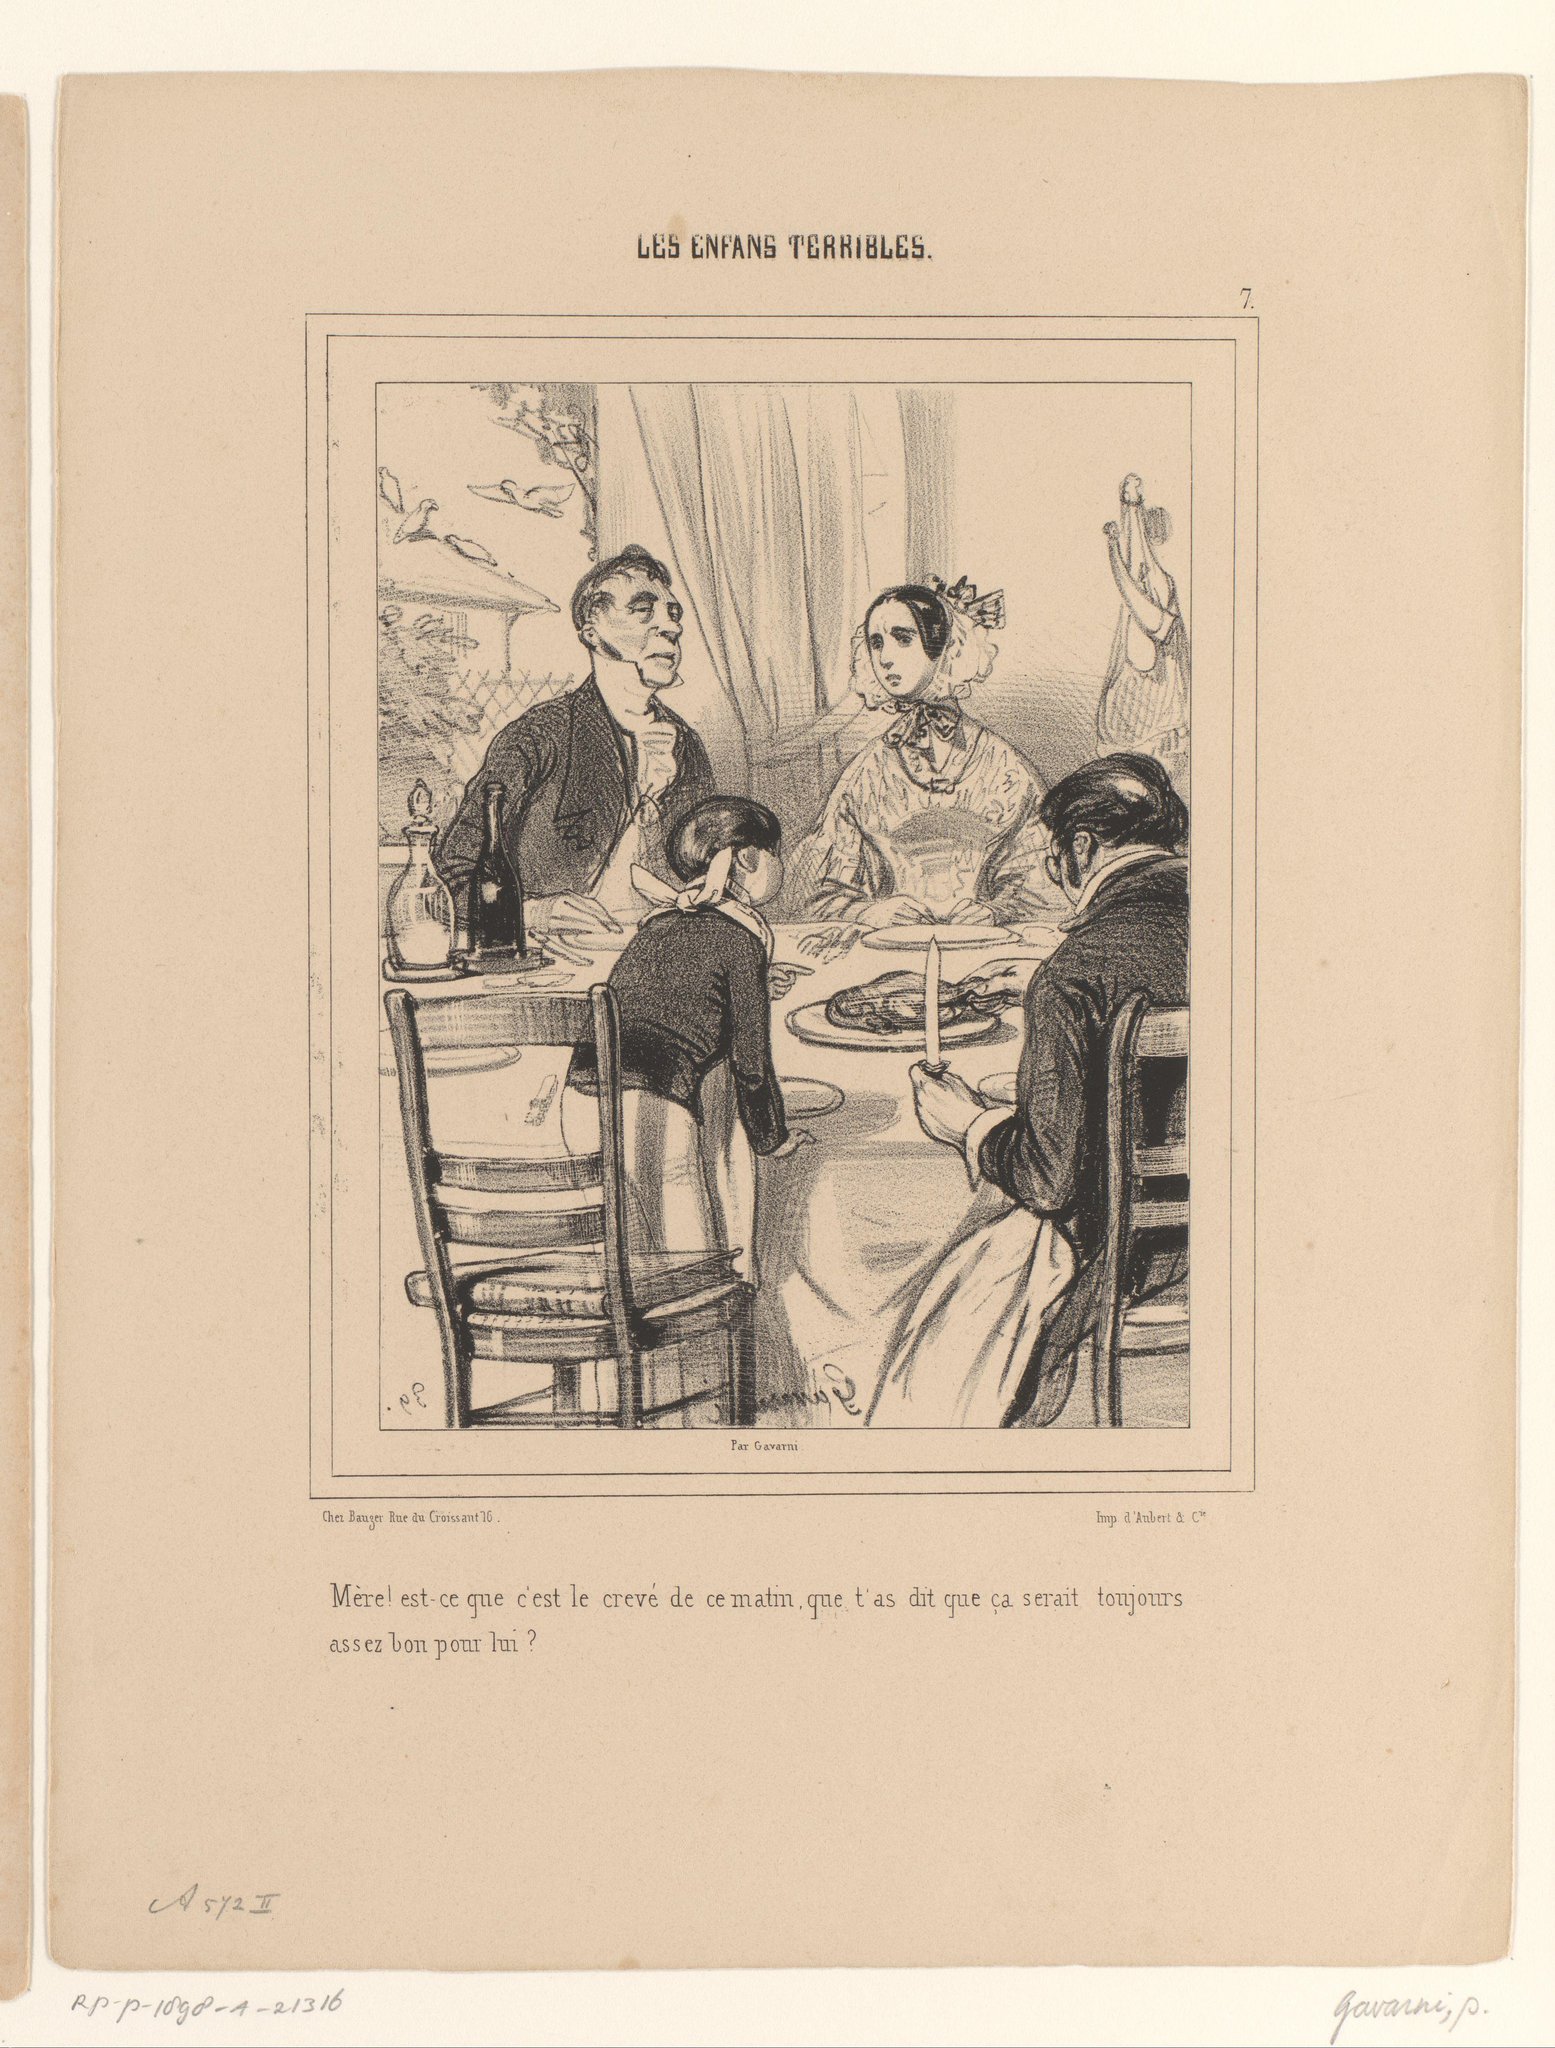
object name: print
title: Mère! est-ce que c'est le crevé de ce matin (...)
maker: paul gavarni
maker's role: draughtsman, print maker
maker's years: 1804-1866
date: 1839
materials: paper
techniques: lithograph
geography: paris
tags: parents with their children, evening meal, dinner, supper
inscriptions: check stamp: Lugt 3855, collector's mark: Lugt 964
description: Het kind maakt een opmerking, waardoor zijn moeder zich ongemakkelijk voelt ten aanzien van de gast.